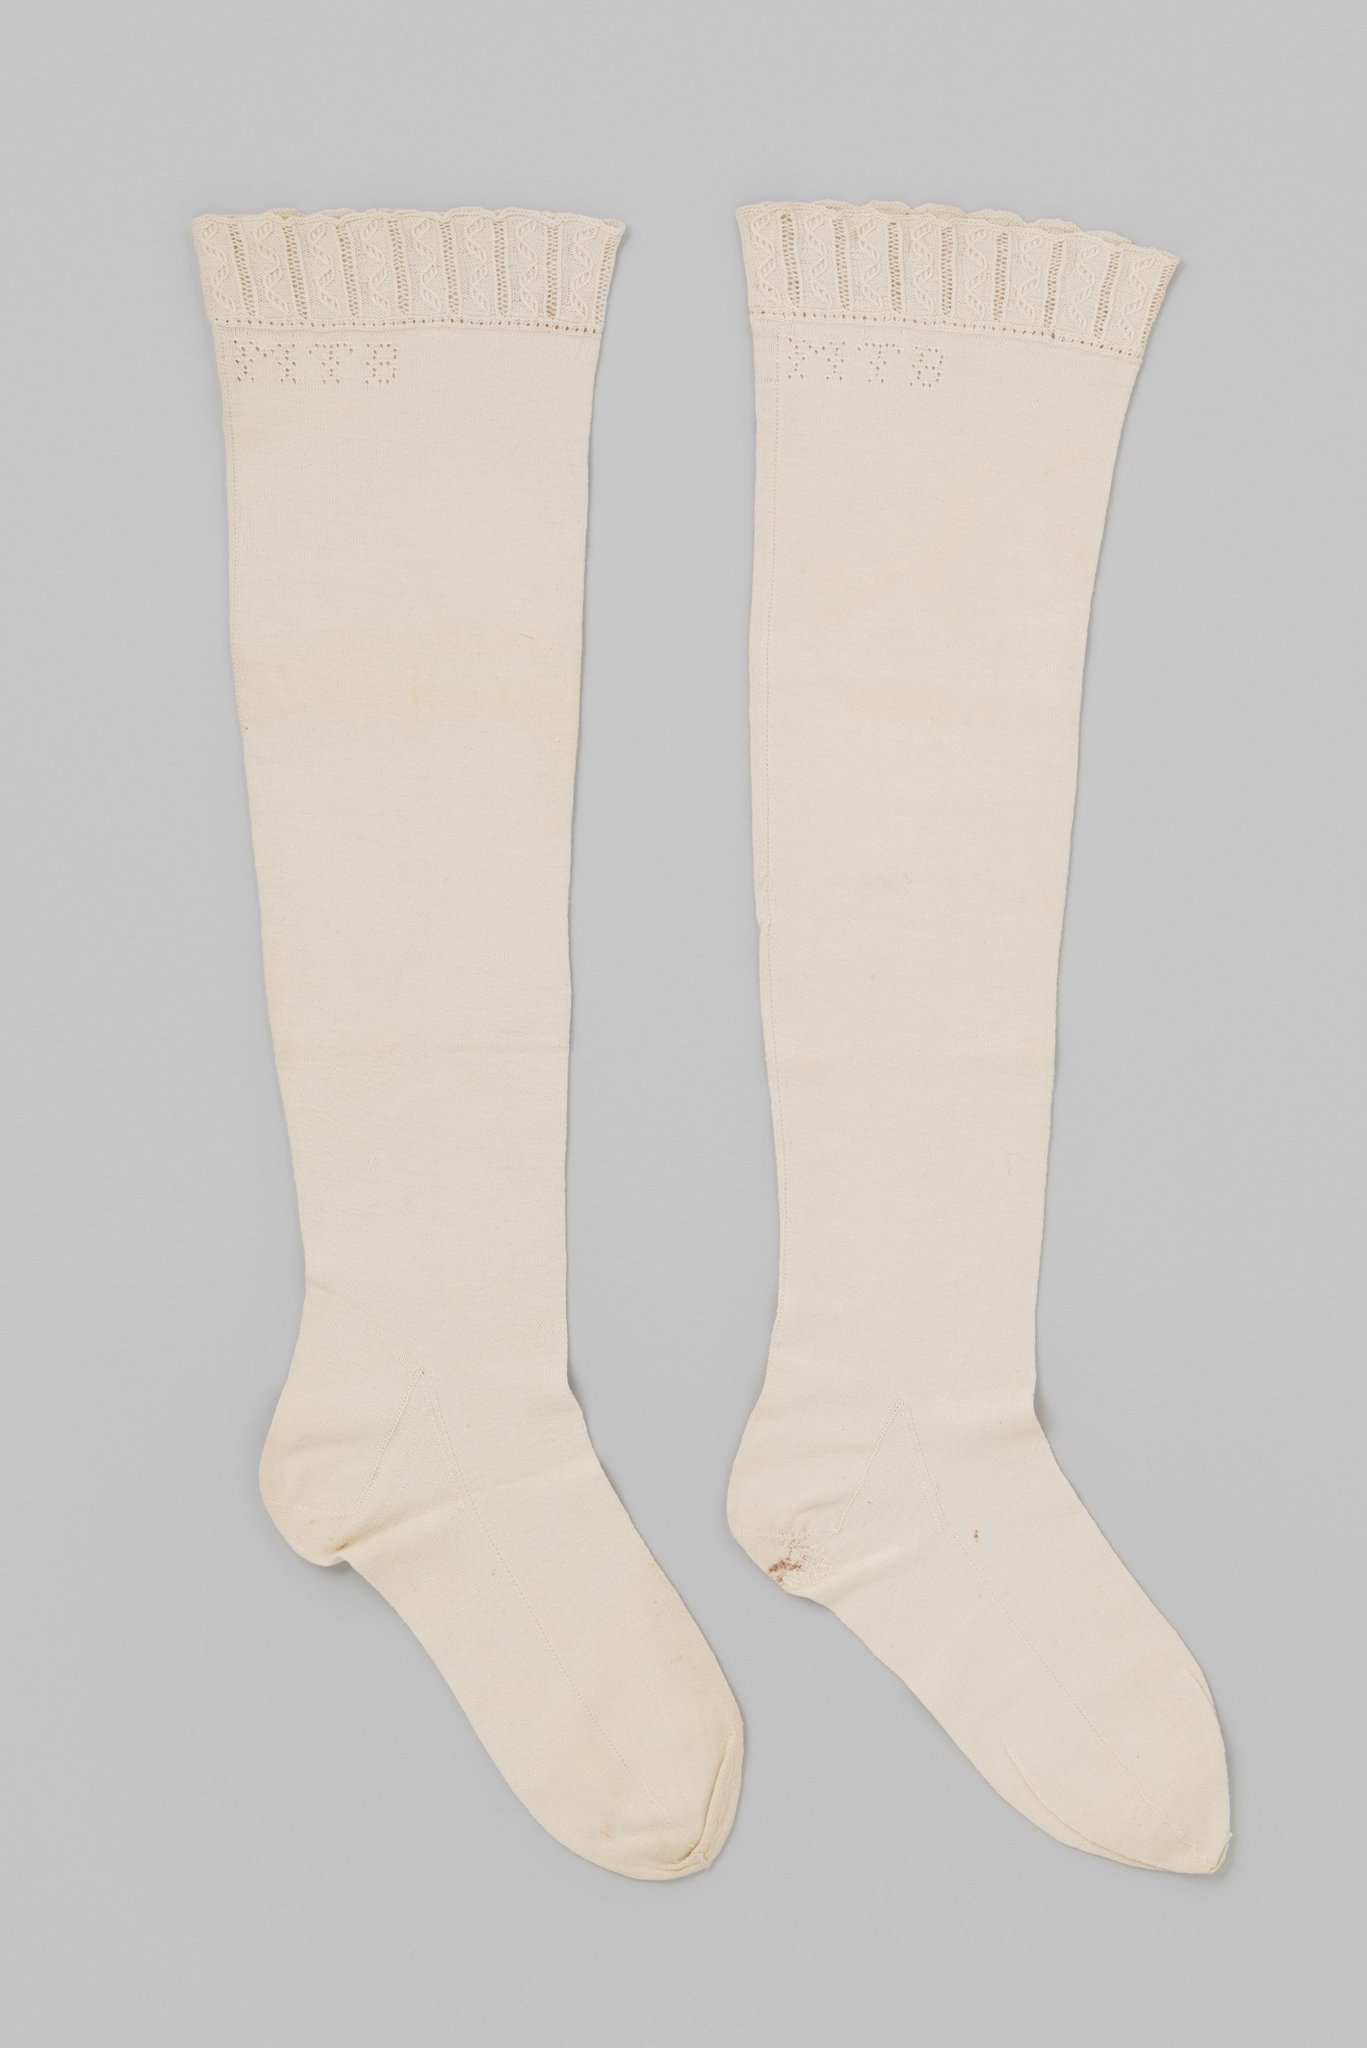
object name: stocking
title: Kous, paar, gebreid met geschulpte bovenrand, versierd met slingers en reliëf tussen opengebreide banden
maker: Anonymous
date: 1880-1900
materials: cotton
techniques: knitting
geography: netherlands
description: Kous van effen gebreide witte katoen met een sierboord van verticale banen in een dubbele helixpatroon, afgewisseld met ajour banen. Naad middenachter. Ingebreid de initialen: 'MTB'. Voorzien van versierde geschulpte bovenrand, met slingers en reliëf tussen opengebreide banden.